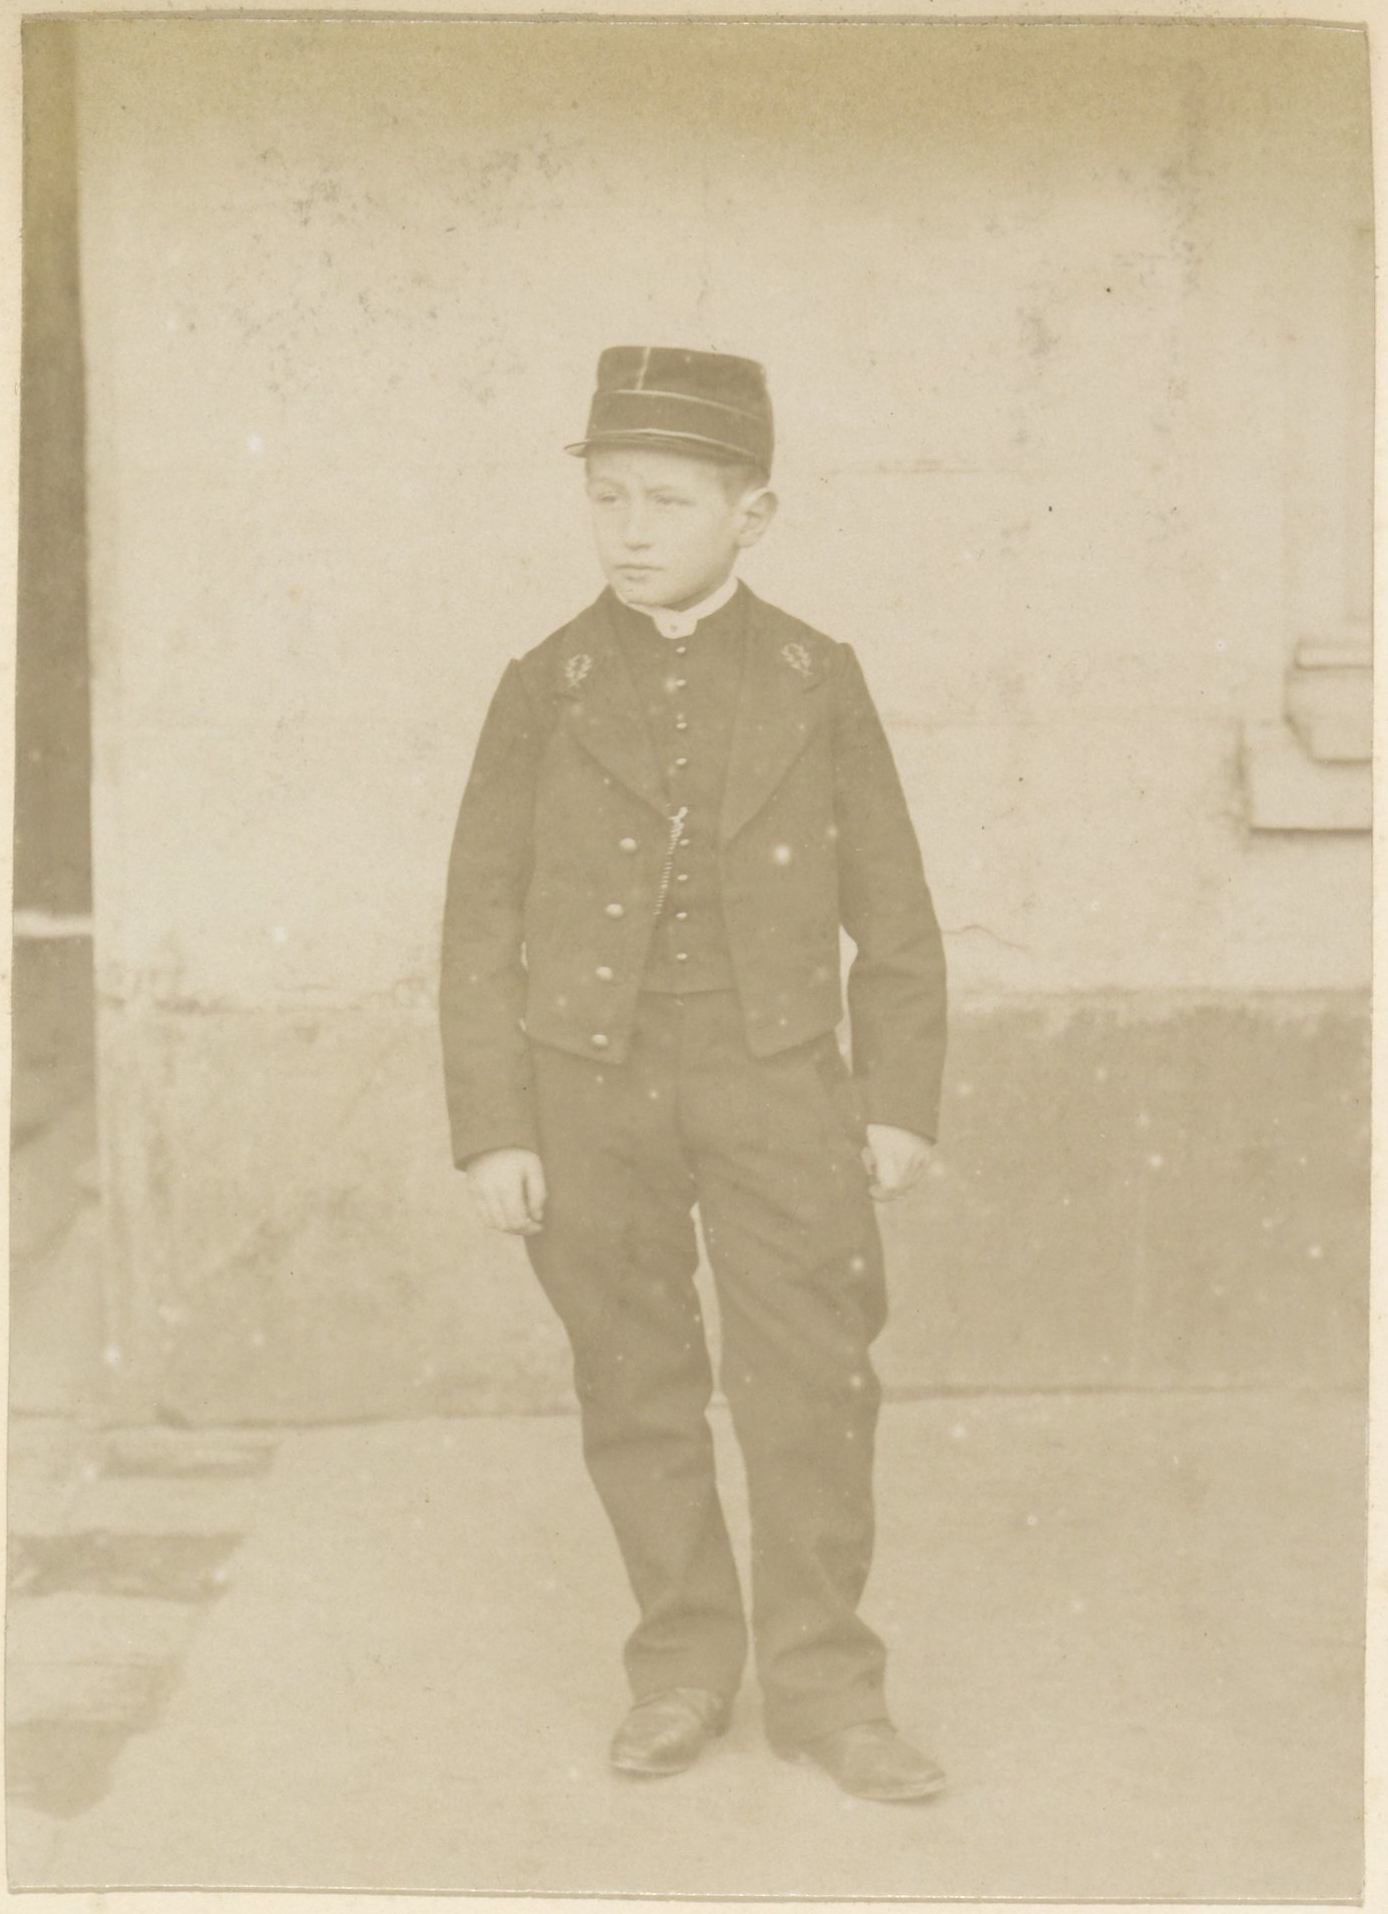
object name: photograph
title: Portret van een Franse jongen in een uniform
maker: Anonymous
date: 1900-1910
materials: paper, photographic support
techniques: albumen print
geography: france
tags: child, head-gear: cap, (military) uniforms, france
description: Onderdeel van Fotoalbum van een Franse amateurfotograaf met opnames van een familie, distilleerderij Delizy & Doistau Fils, het leger en bezienswaardigheden in Frankrijk.